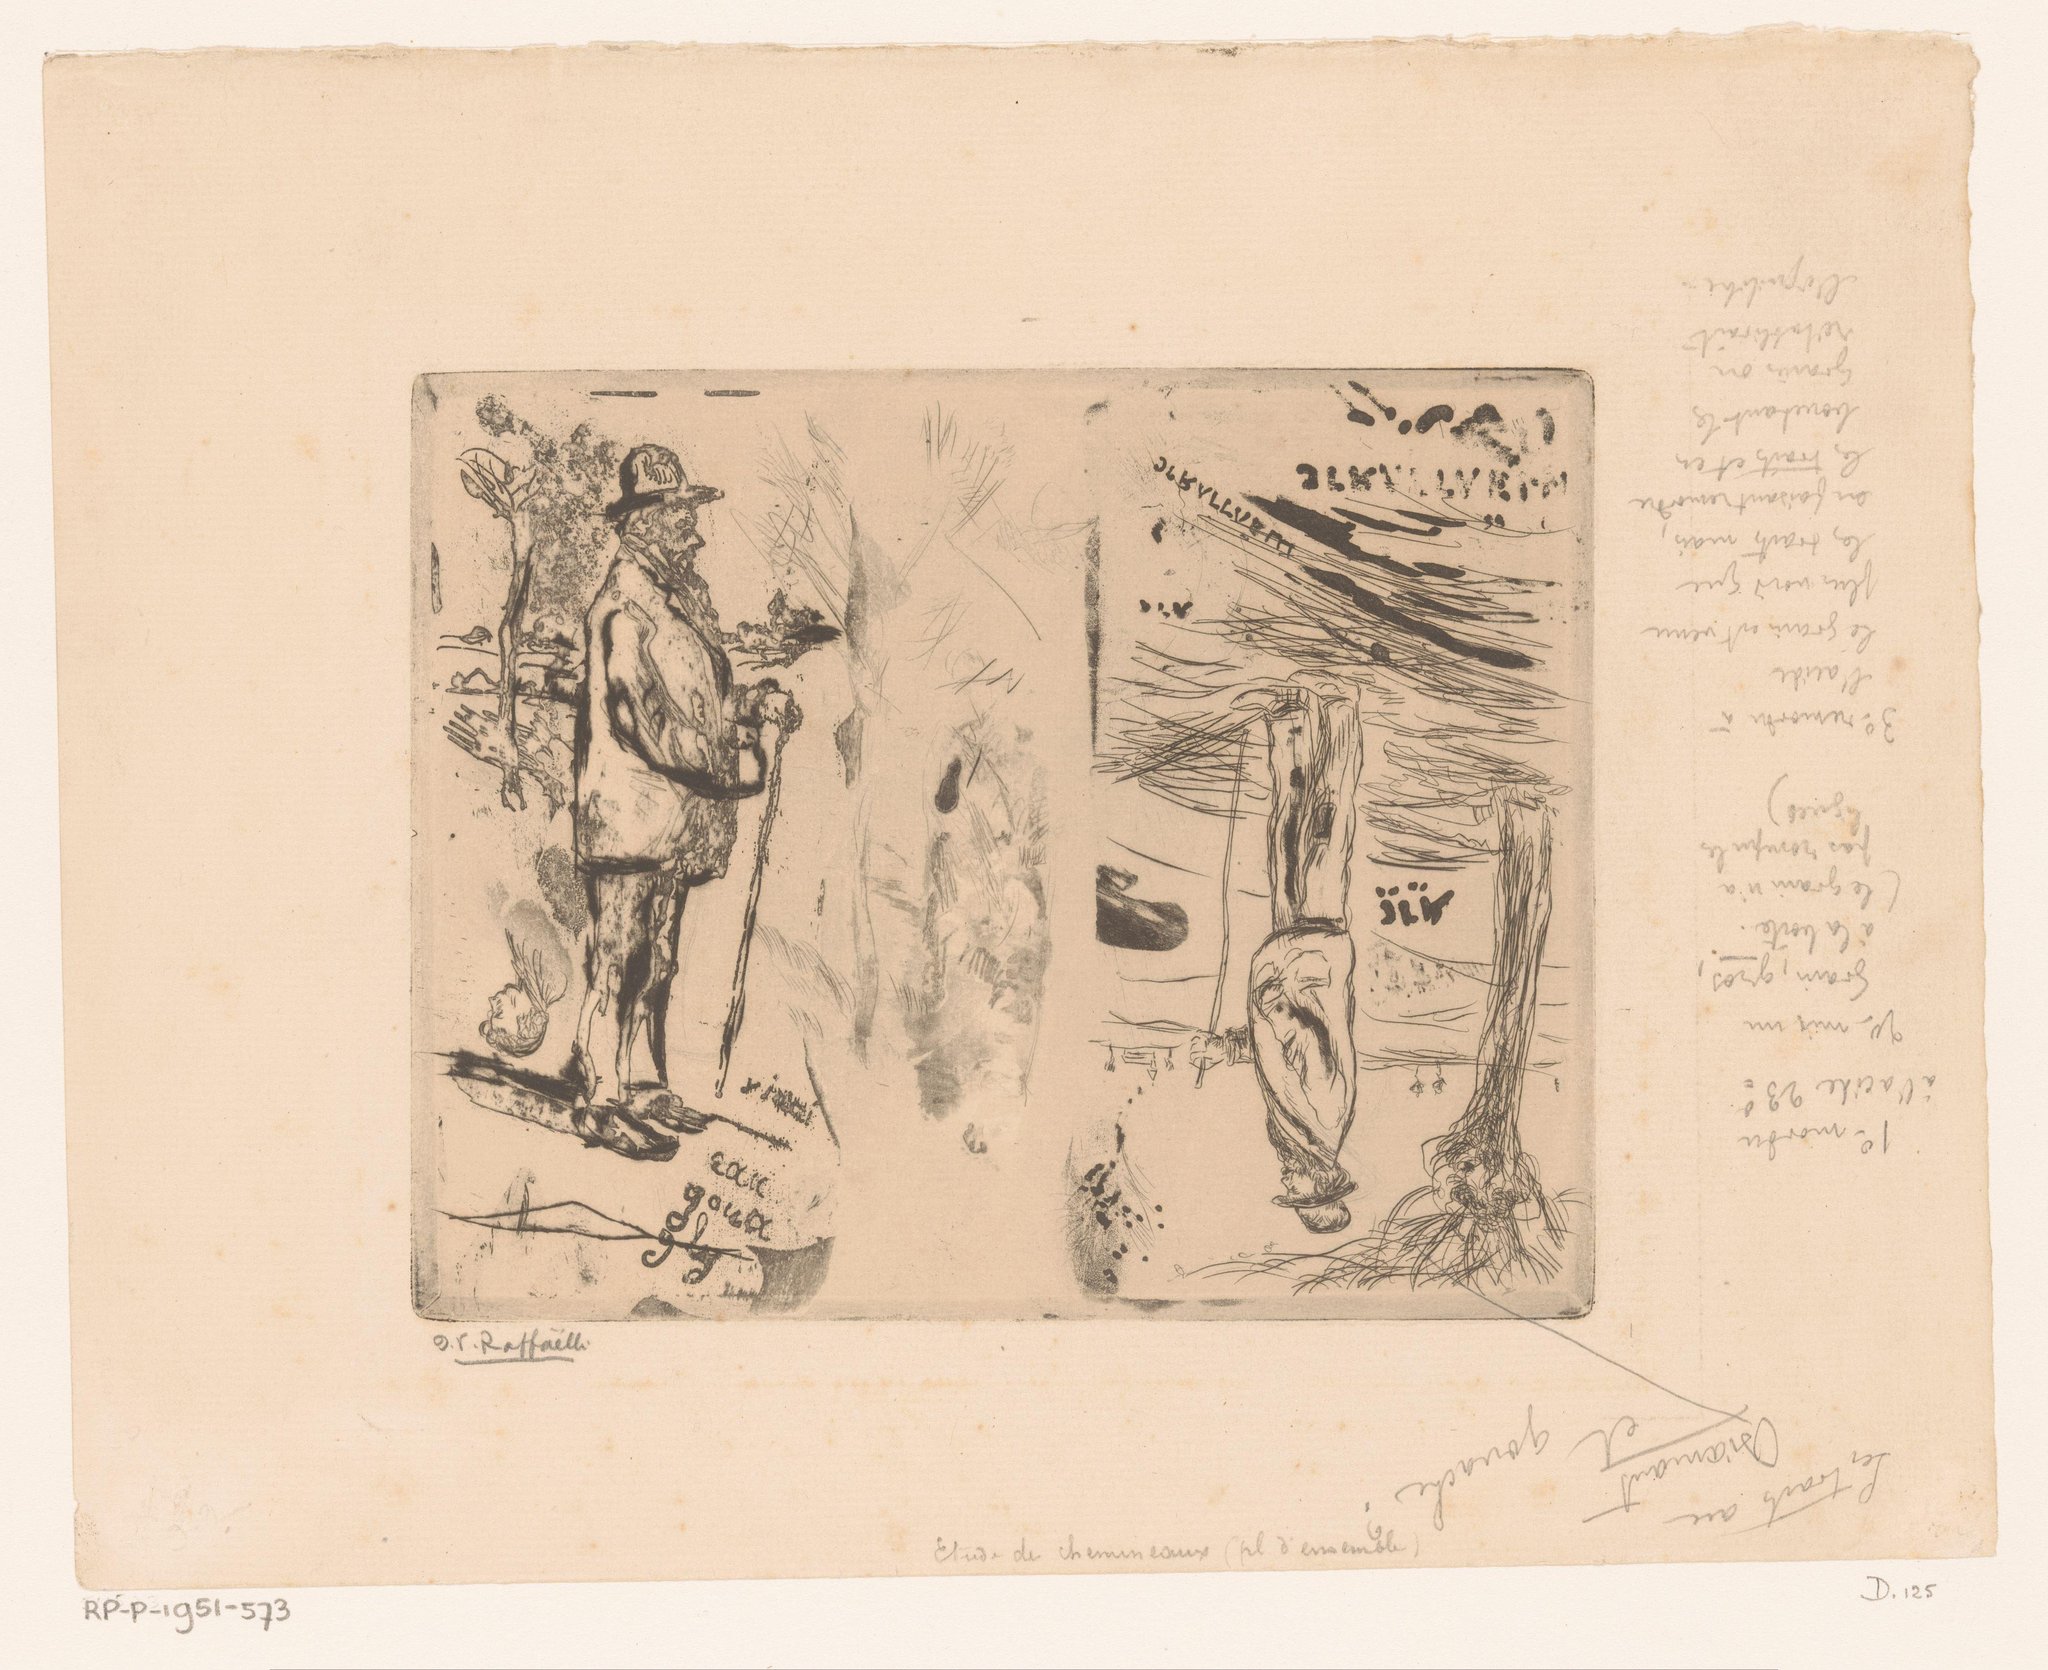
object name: print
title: Studie van staande zwerver met stok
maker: jean françois raffaëlli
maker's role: print maker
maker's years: 1850-1924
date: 1860-1924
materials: paper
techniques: etching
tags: adult man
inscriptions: collector's mark: Lugt 2228, annotation: ‘Les traits au Diamant et gouache [...] grain gros [...]’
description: Links een man met stok, rechts een vergelijkbare compositie maar dan ondersteboven gekeerd.